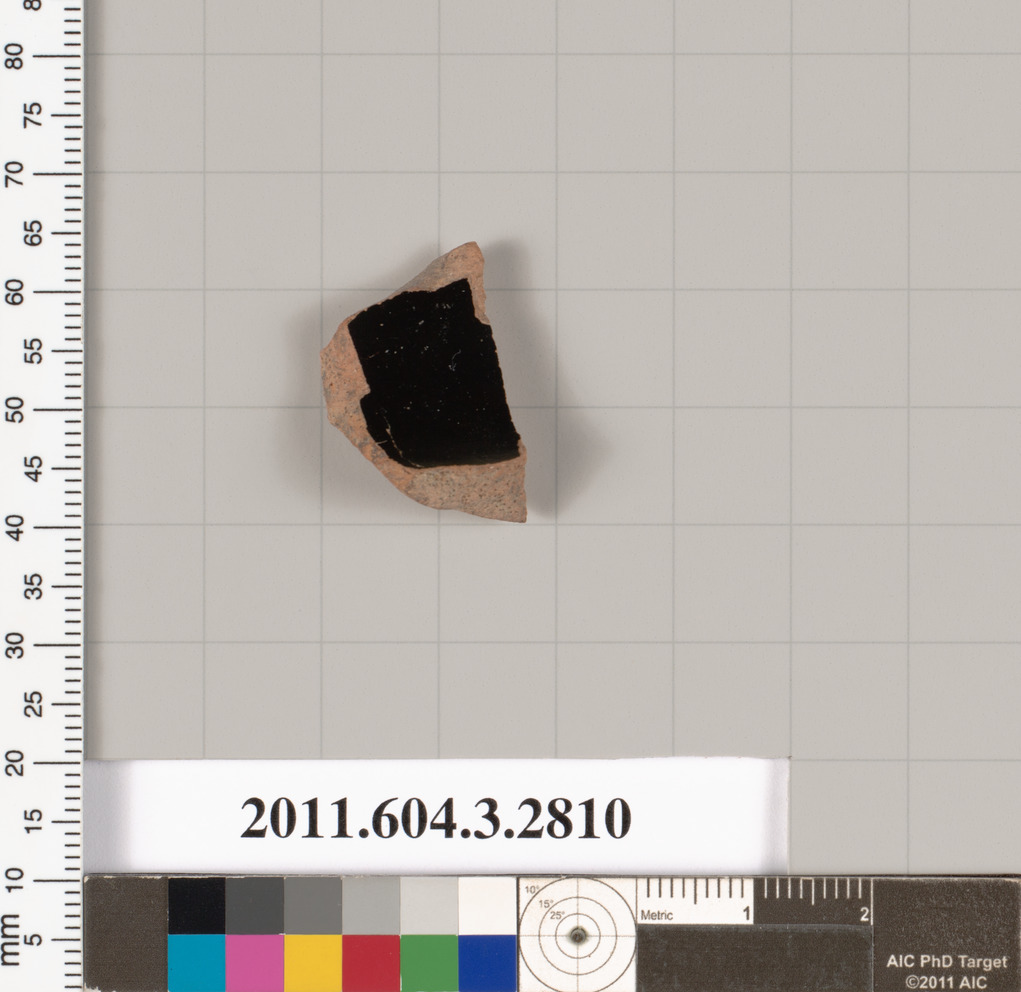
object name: oinochoe or olpe fragment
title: Terracotta fragment of an oinochoe (jug) or olpe (jug)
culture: greek, attic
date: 600-401 BCE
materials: terracotta